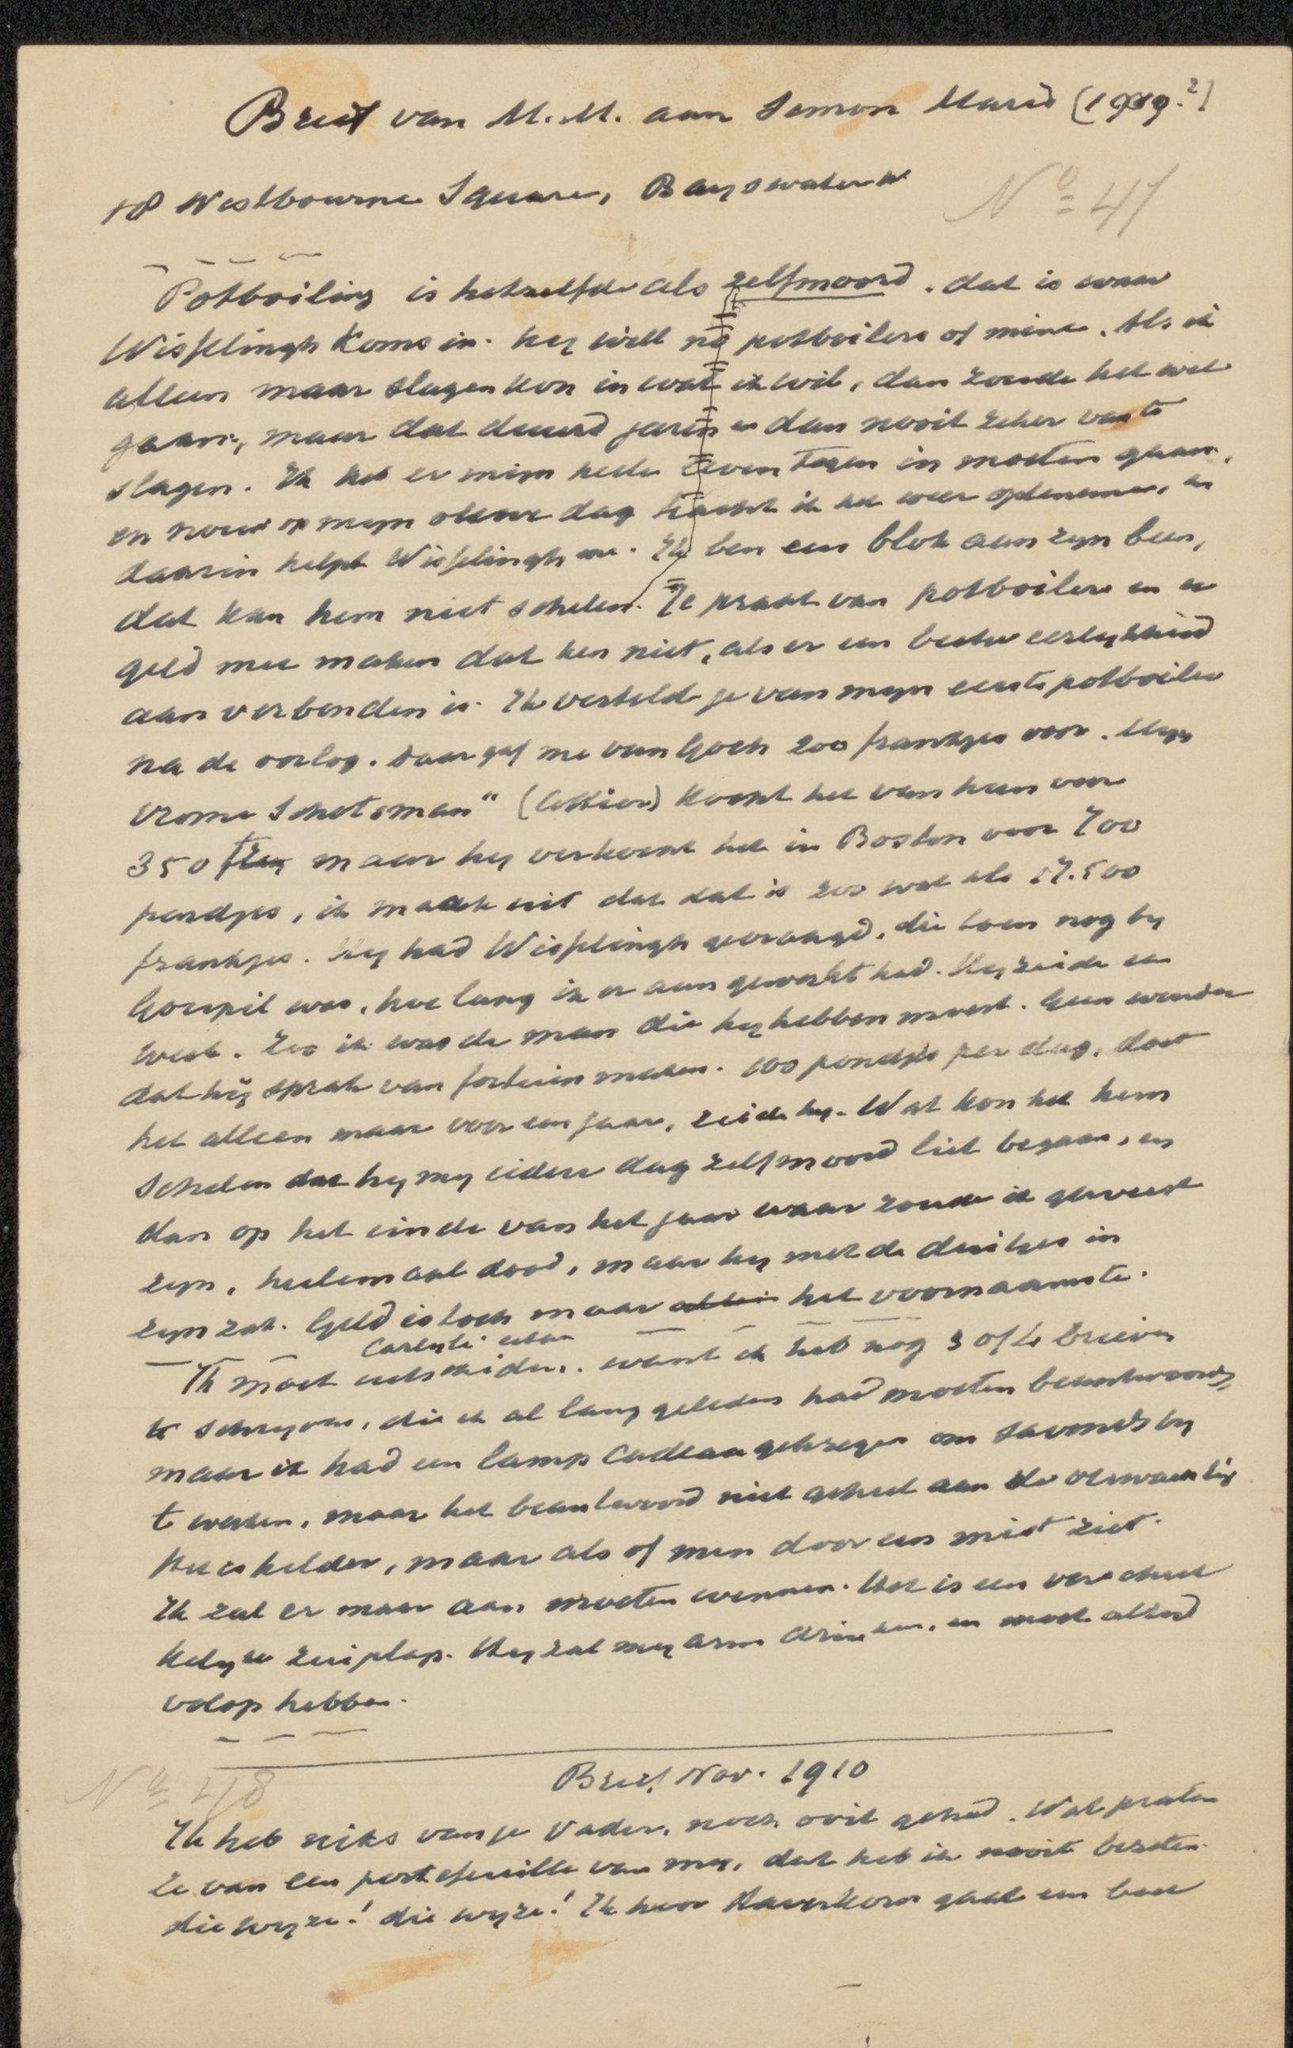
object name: letter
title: Citaten uit brieven aan Simon Maris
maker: pieter haverkorn van rijsewijk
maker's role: museumdirecteur, publicist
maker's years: 1839-1919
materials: ink, paper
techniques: pen, writing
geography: london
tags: the hague, amsterdam, painter, simon maris, elbert jan van wisselingh, art trade, art shop, photography, cinematography, painting (including book-illumination, miniature-painting), paris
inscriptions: collector's mark: Lugt 2233